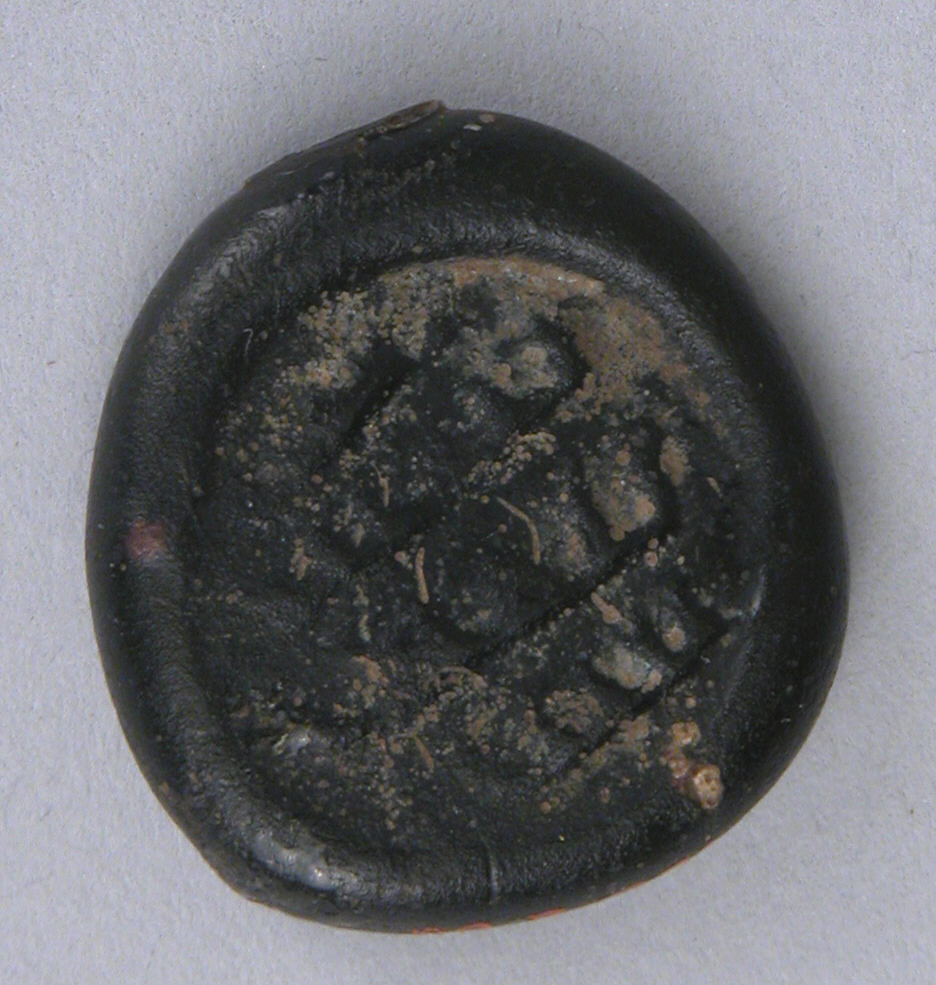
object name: coin weight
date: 1201-1400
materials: glass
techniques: stamping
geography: egypt